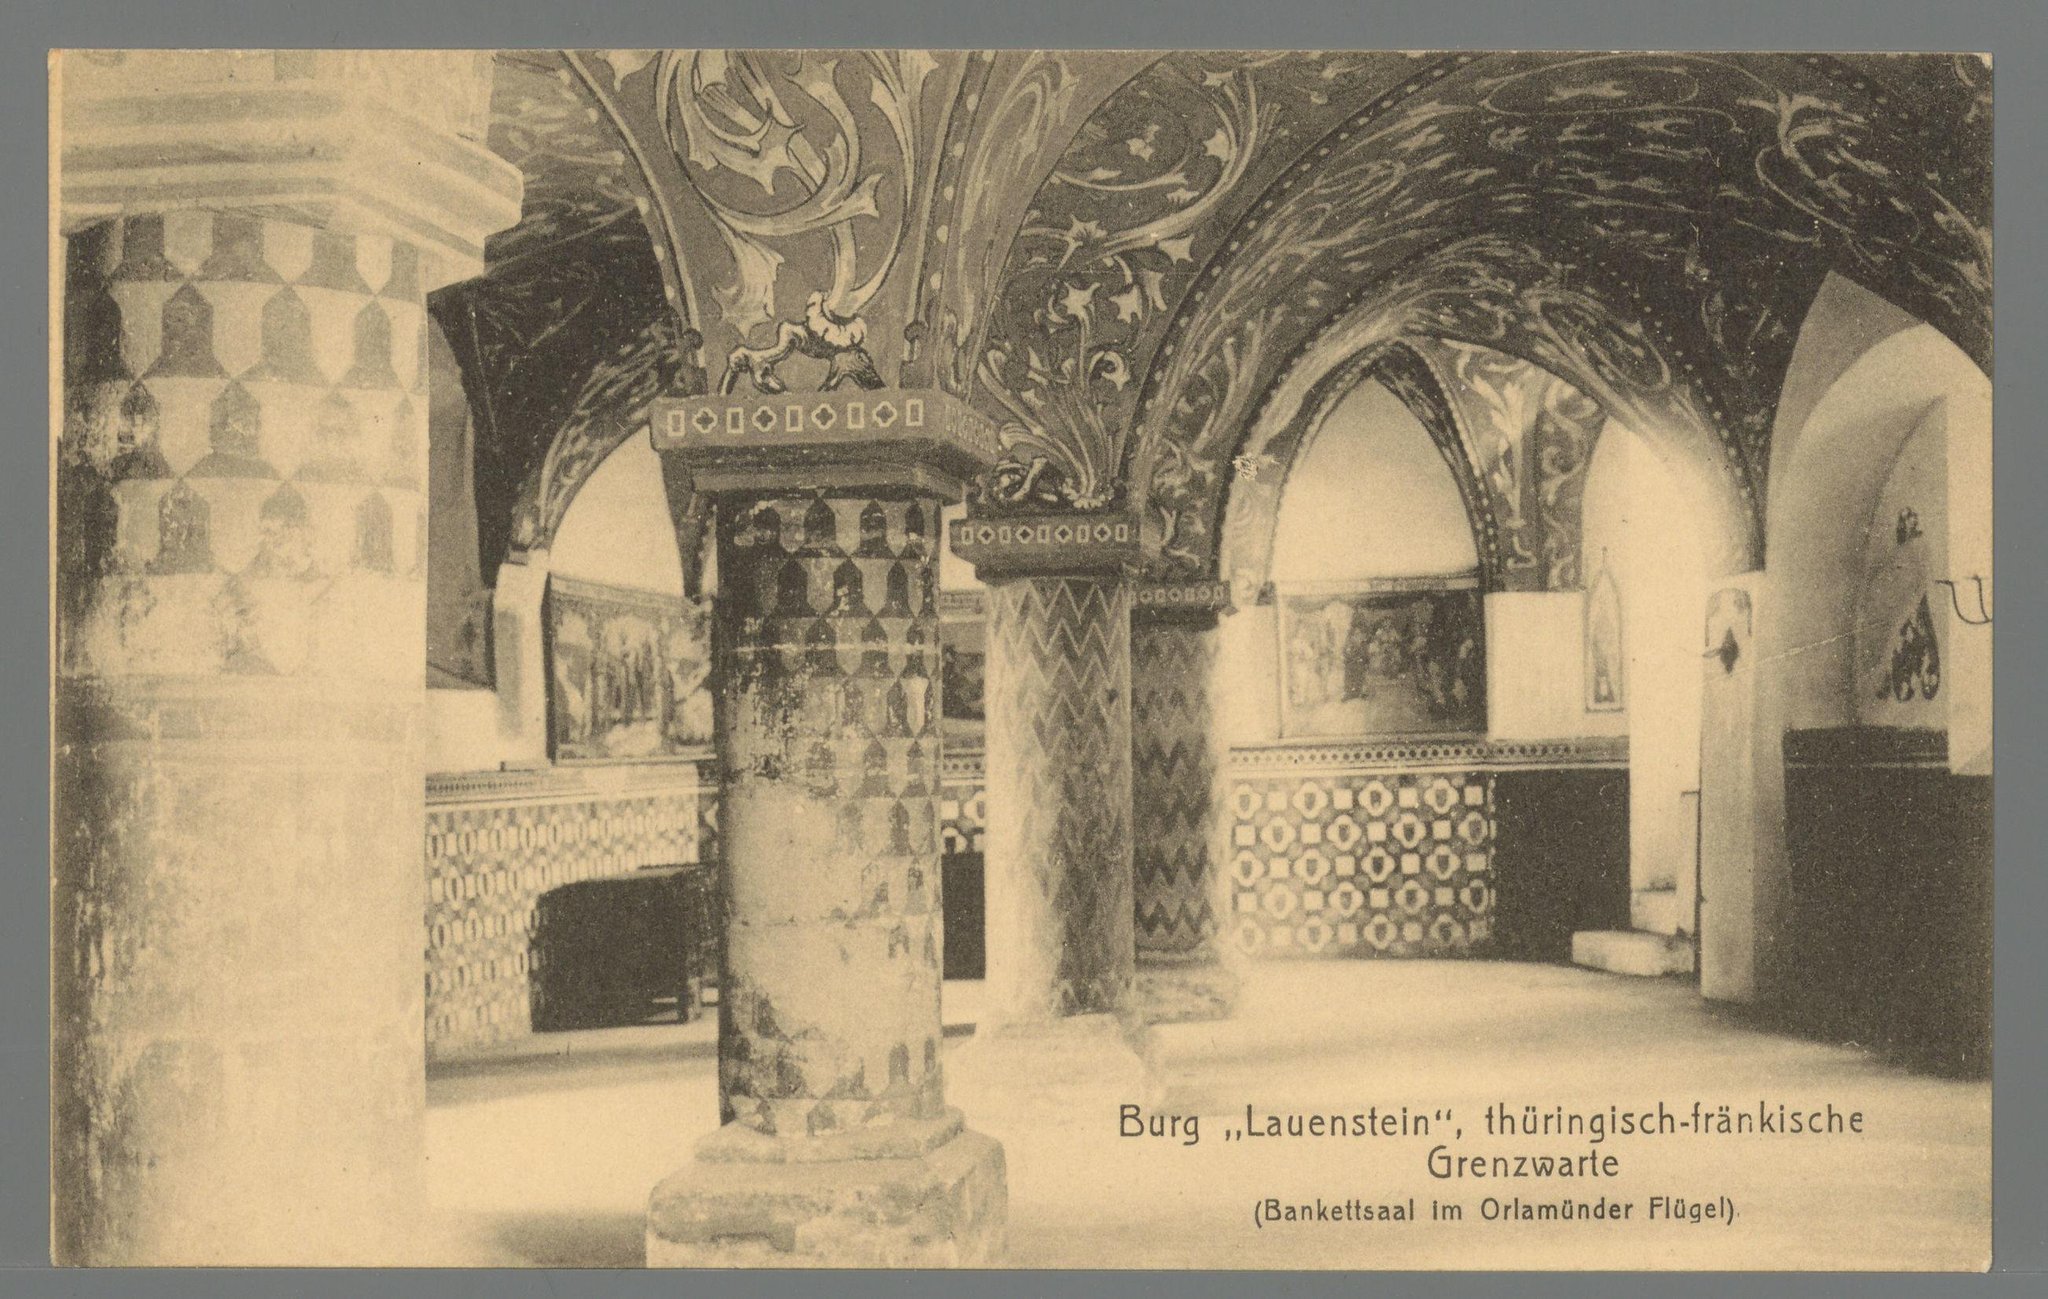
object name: ansichtkaart, prentbriefkaart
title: Burg "Lauenstein", thüringisch-fränkische Grenzwarte (Bankettsaal im Orlamünder Flügel)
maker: Anonymous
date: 1905-1930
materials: cardboard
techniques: photograph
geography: ludwigsstadt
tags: castle, interior of the house, vault ~ architecture